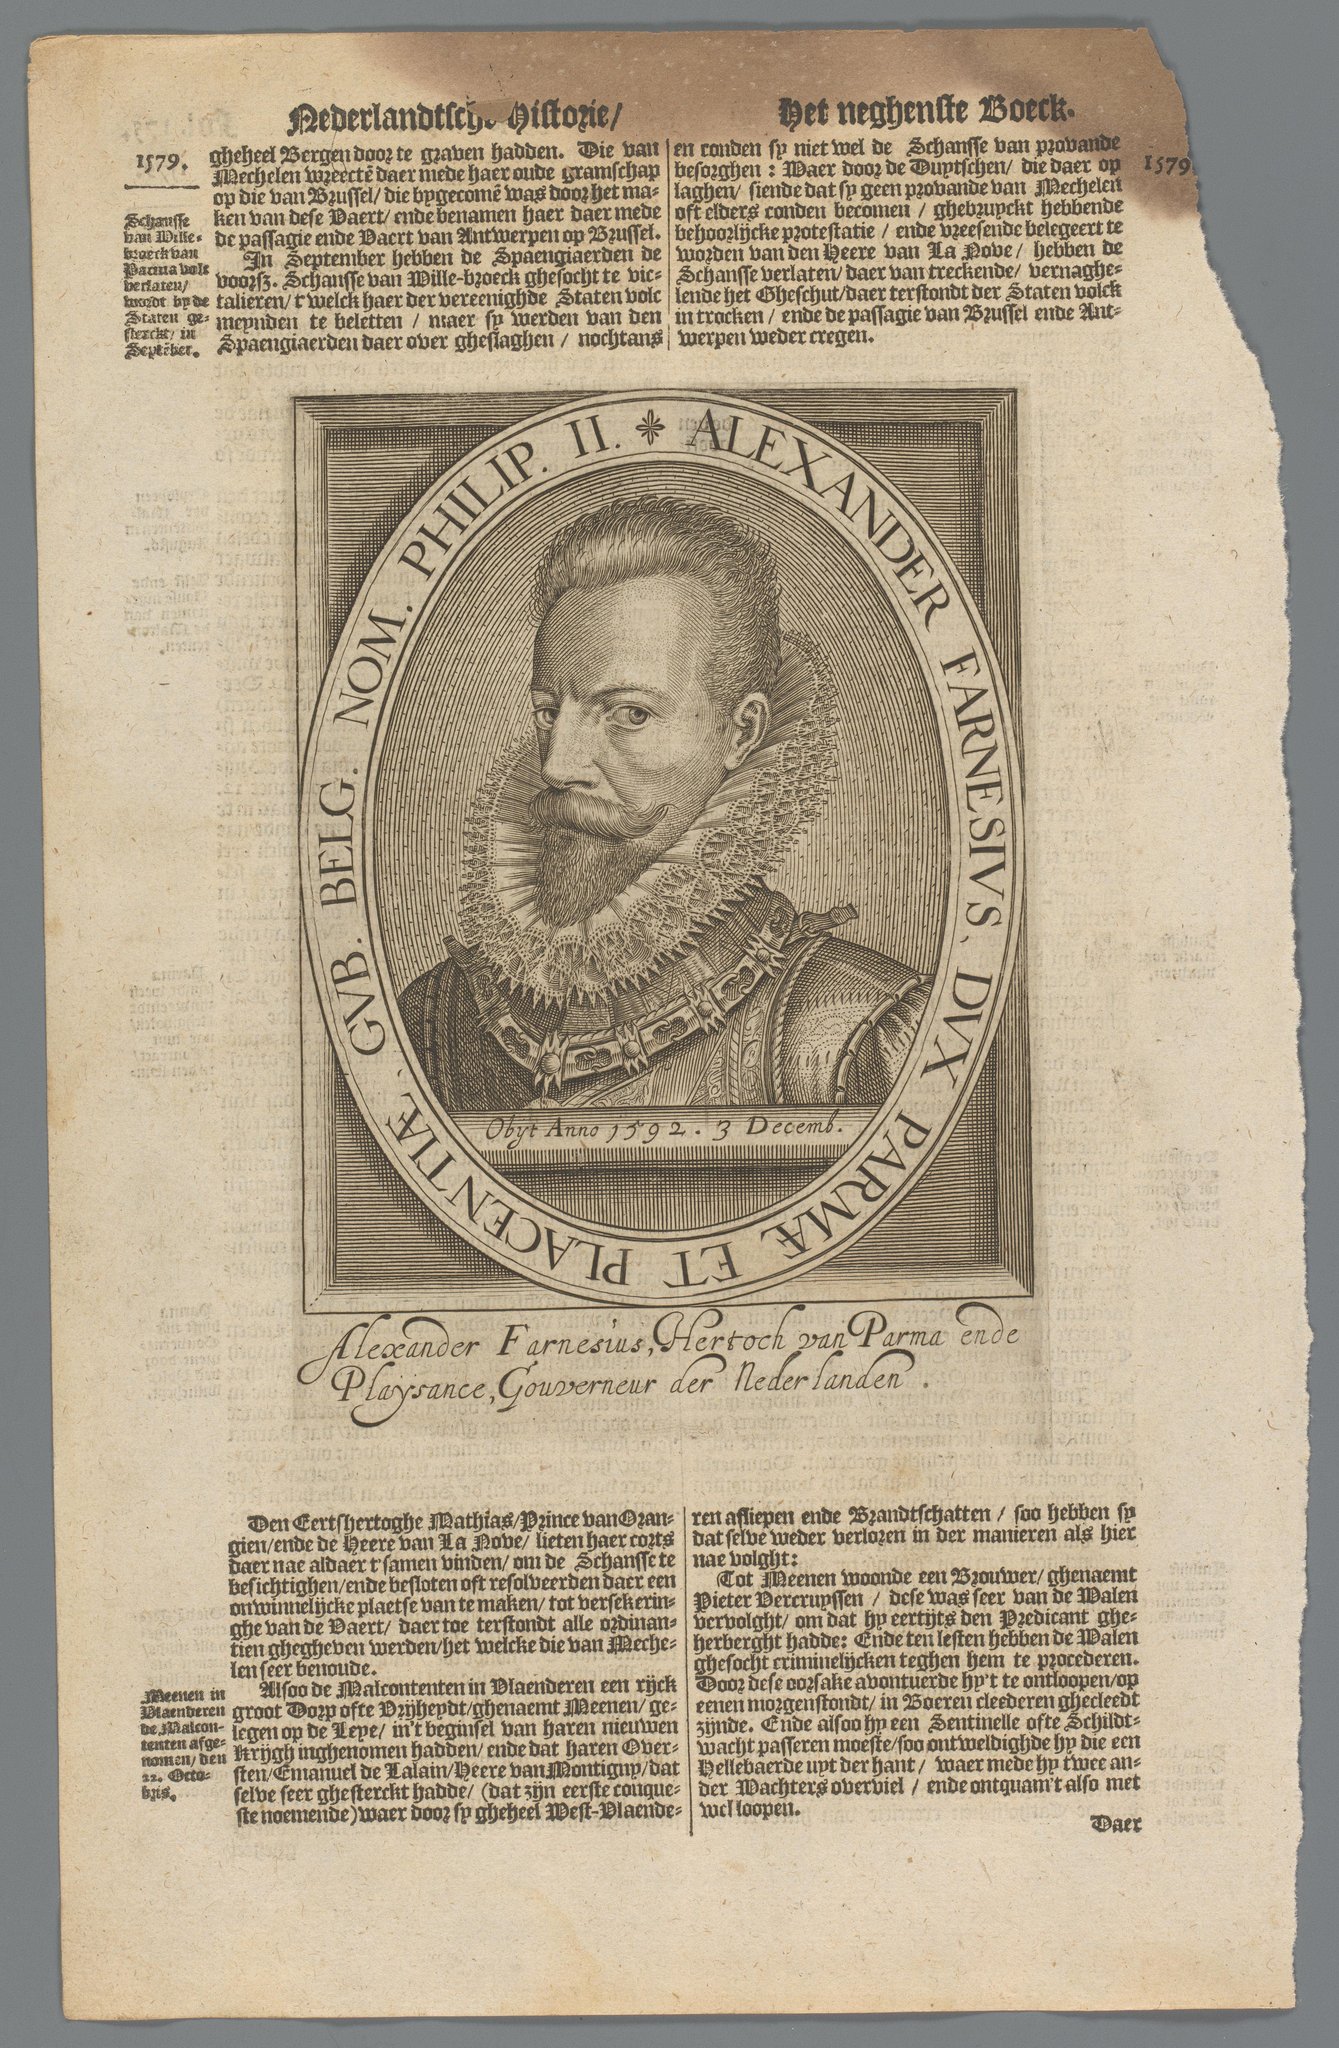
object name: text sheet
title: Portret van Alessandro Farnese, landvoogd van de Nederlanden en hertog van Parma en Piacenza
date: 1614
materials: paper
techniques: engraving, letterpress printing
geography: the hague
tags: rome, alessandro farnese (landvoogd van de nederlanden en hertog van parma en piacenza), historical persons, regent, substitute ruler; viceroy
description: Prent uit: Meteren, Emanuel van. Historie der Nederlandscher ende haerder na-buren oorlogen ende geschiedenissen (...). Den Haag: Hillebrant Iacobsz. van Wouw, 1614. Prent ook gebruikt in: Meteren, Emanuel van. Historie der Nederlandscher ende haerder na-buren oorlogen ende geschiedenissen (...). Den Haag: weduwe en erfgenamen van Hillebrant Iacobsz. van Wouw, 1623.